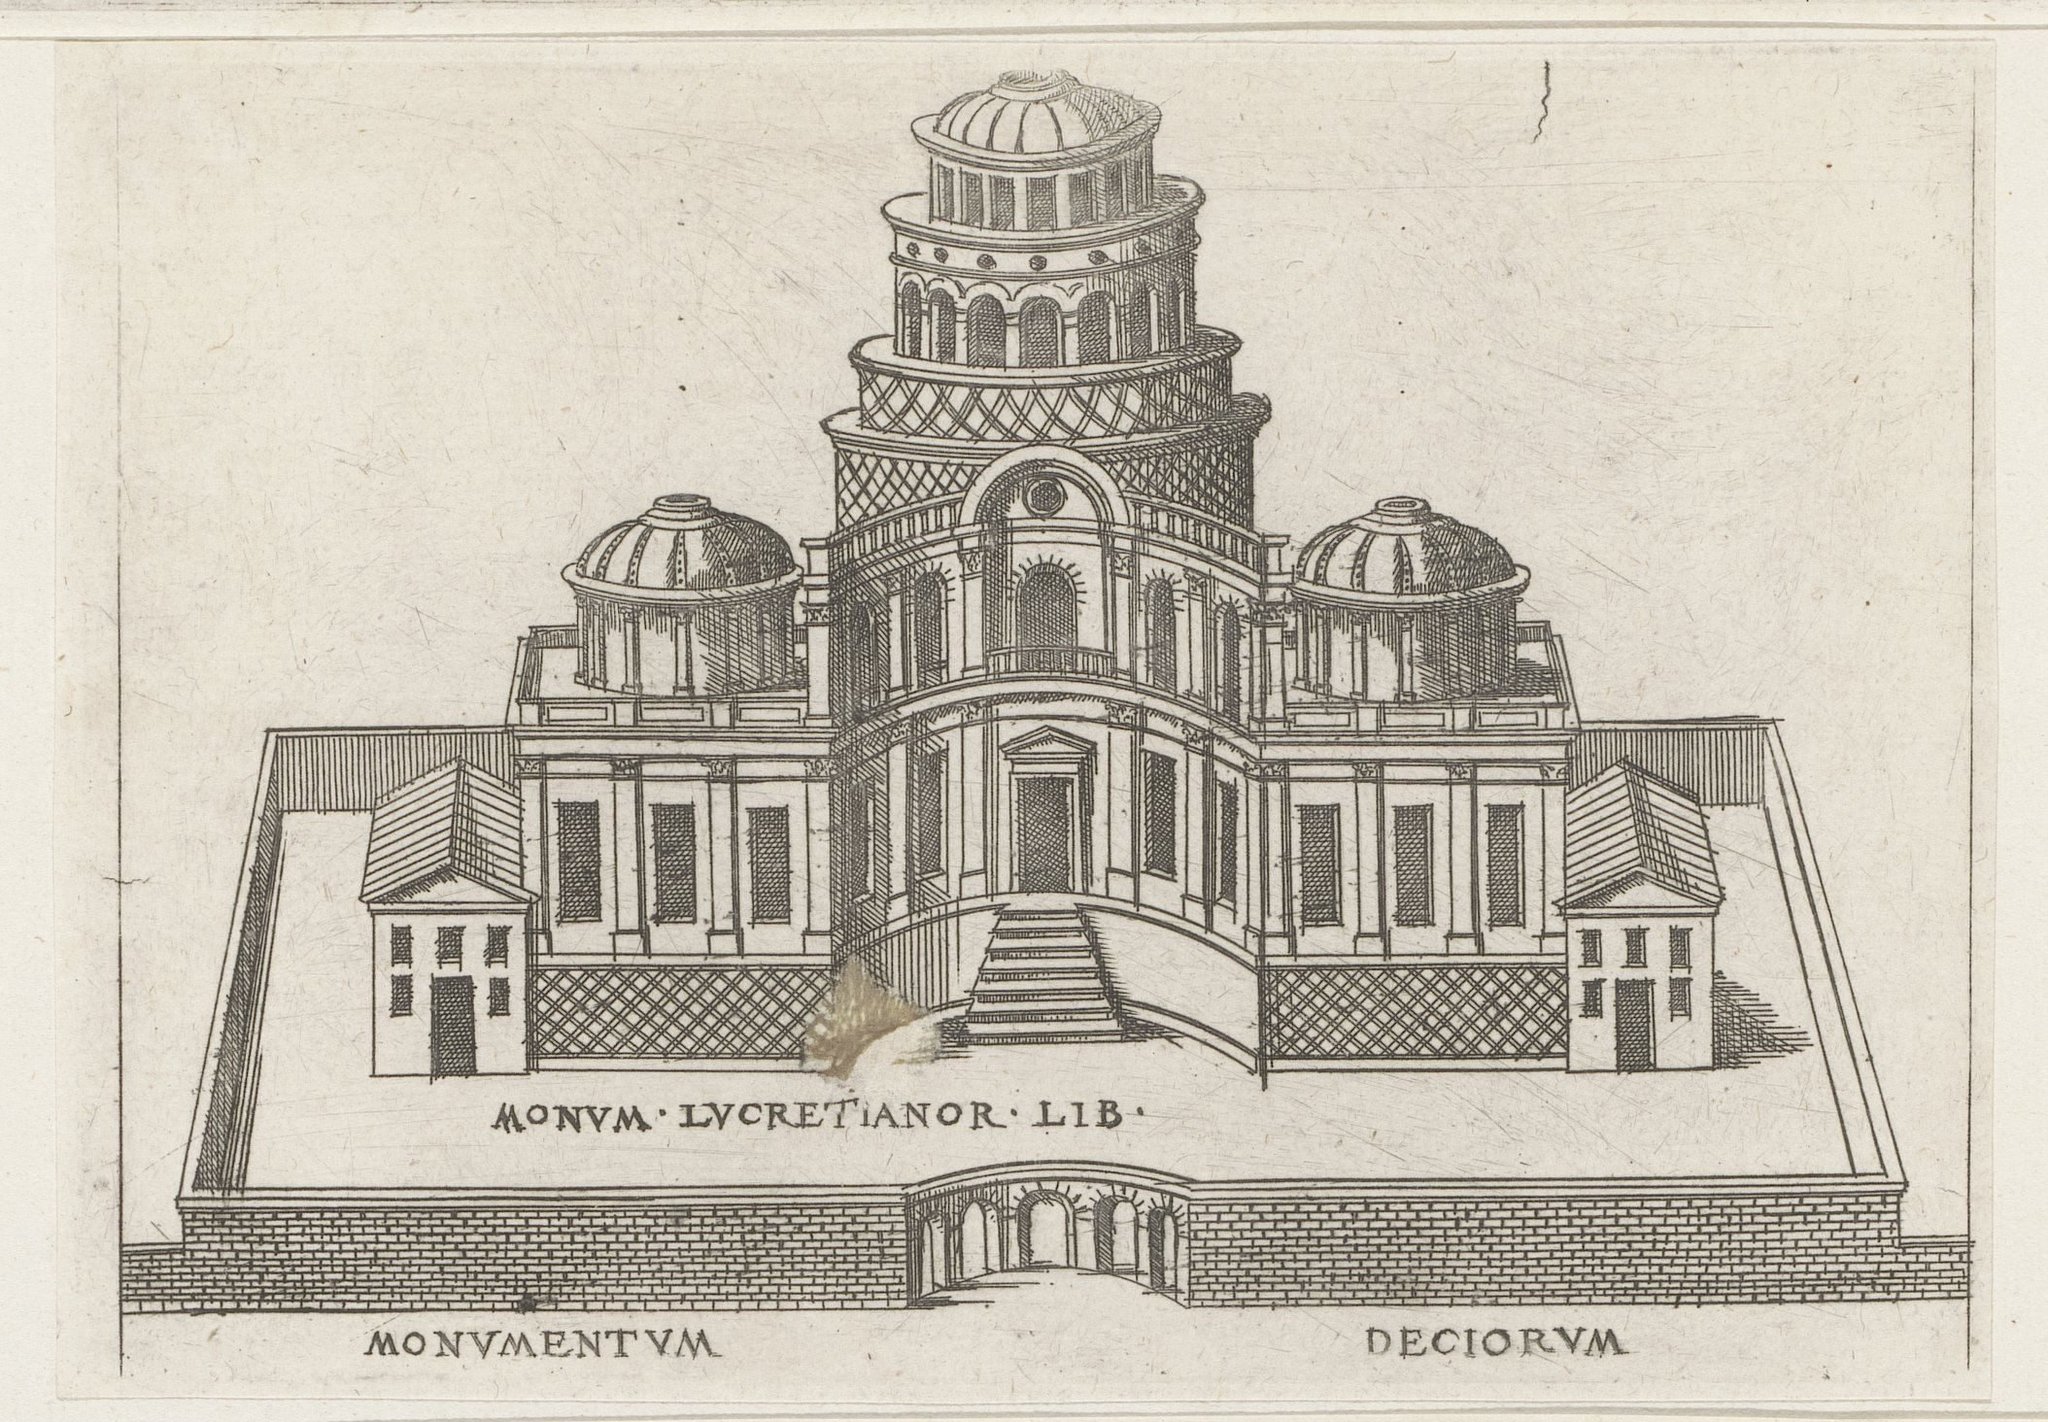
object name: print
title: Monum. Lycretianor Lib./ Monumentum Deciorum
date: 1584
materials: paper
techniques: etching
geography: france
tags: representation of real building (either existing or having existed), rome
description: Deze prent maakt deel uit van een serie van 98 prenten gedrukt op 48 bladen. De bladen zijn verknipt en een selectie van de losse prenten is in dit album geplakt.